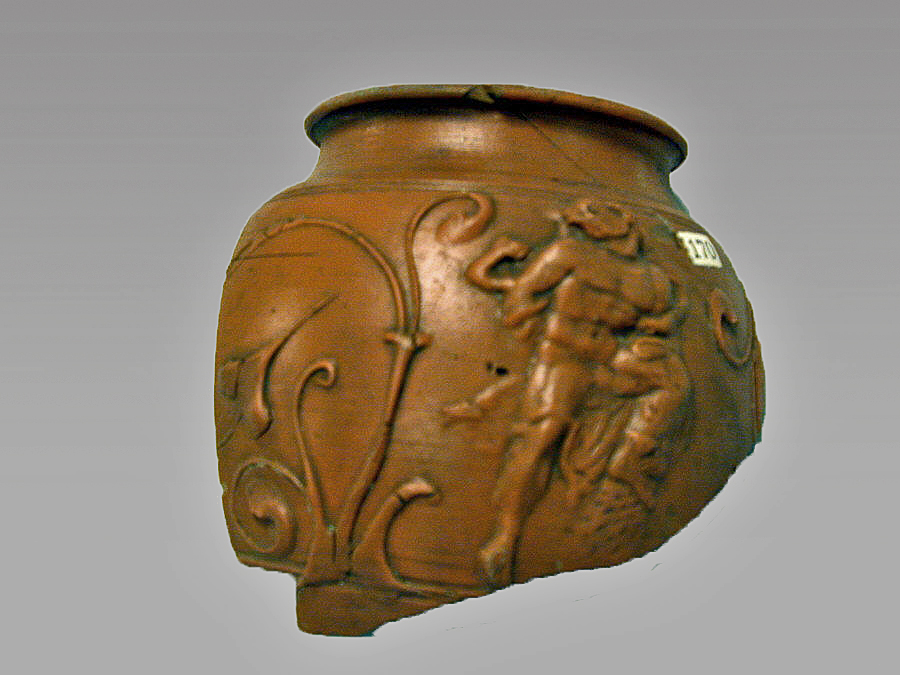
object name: vase fragment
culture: roman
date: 670 BCE-330 CE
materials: terracotta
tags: men,serpents